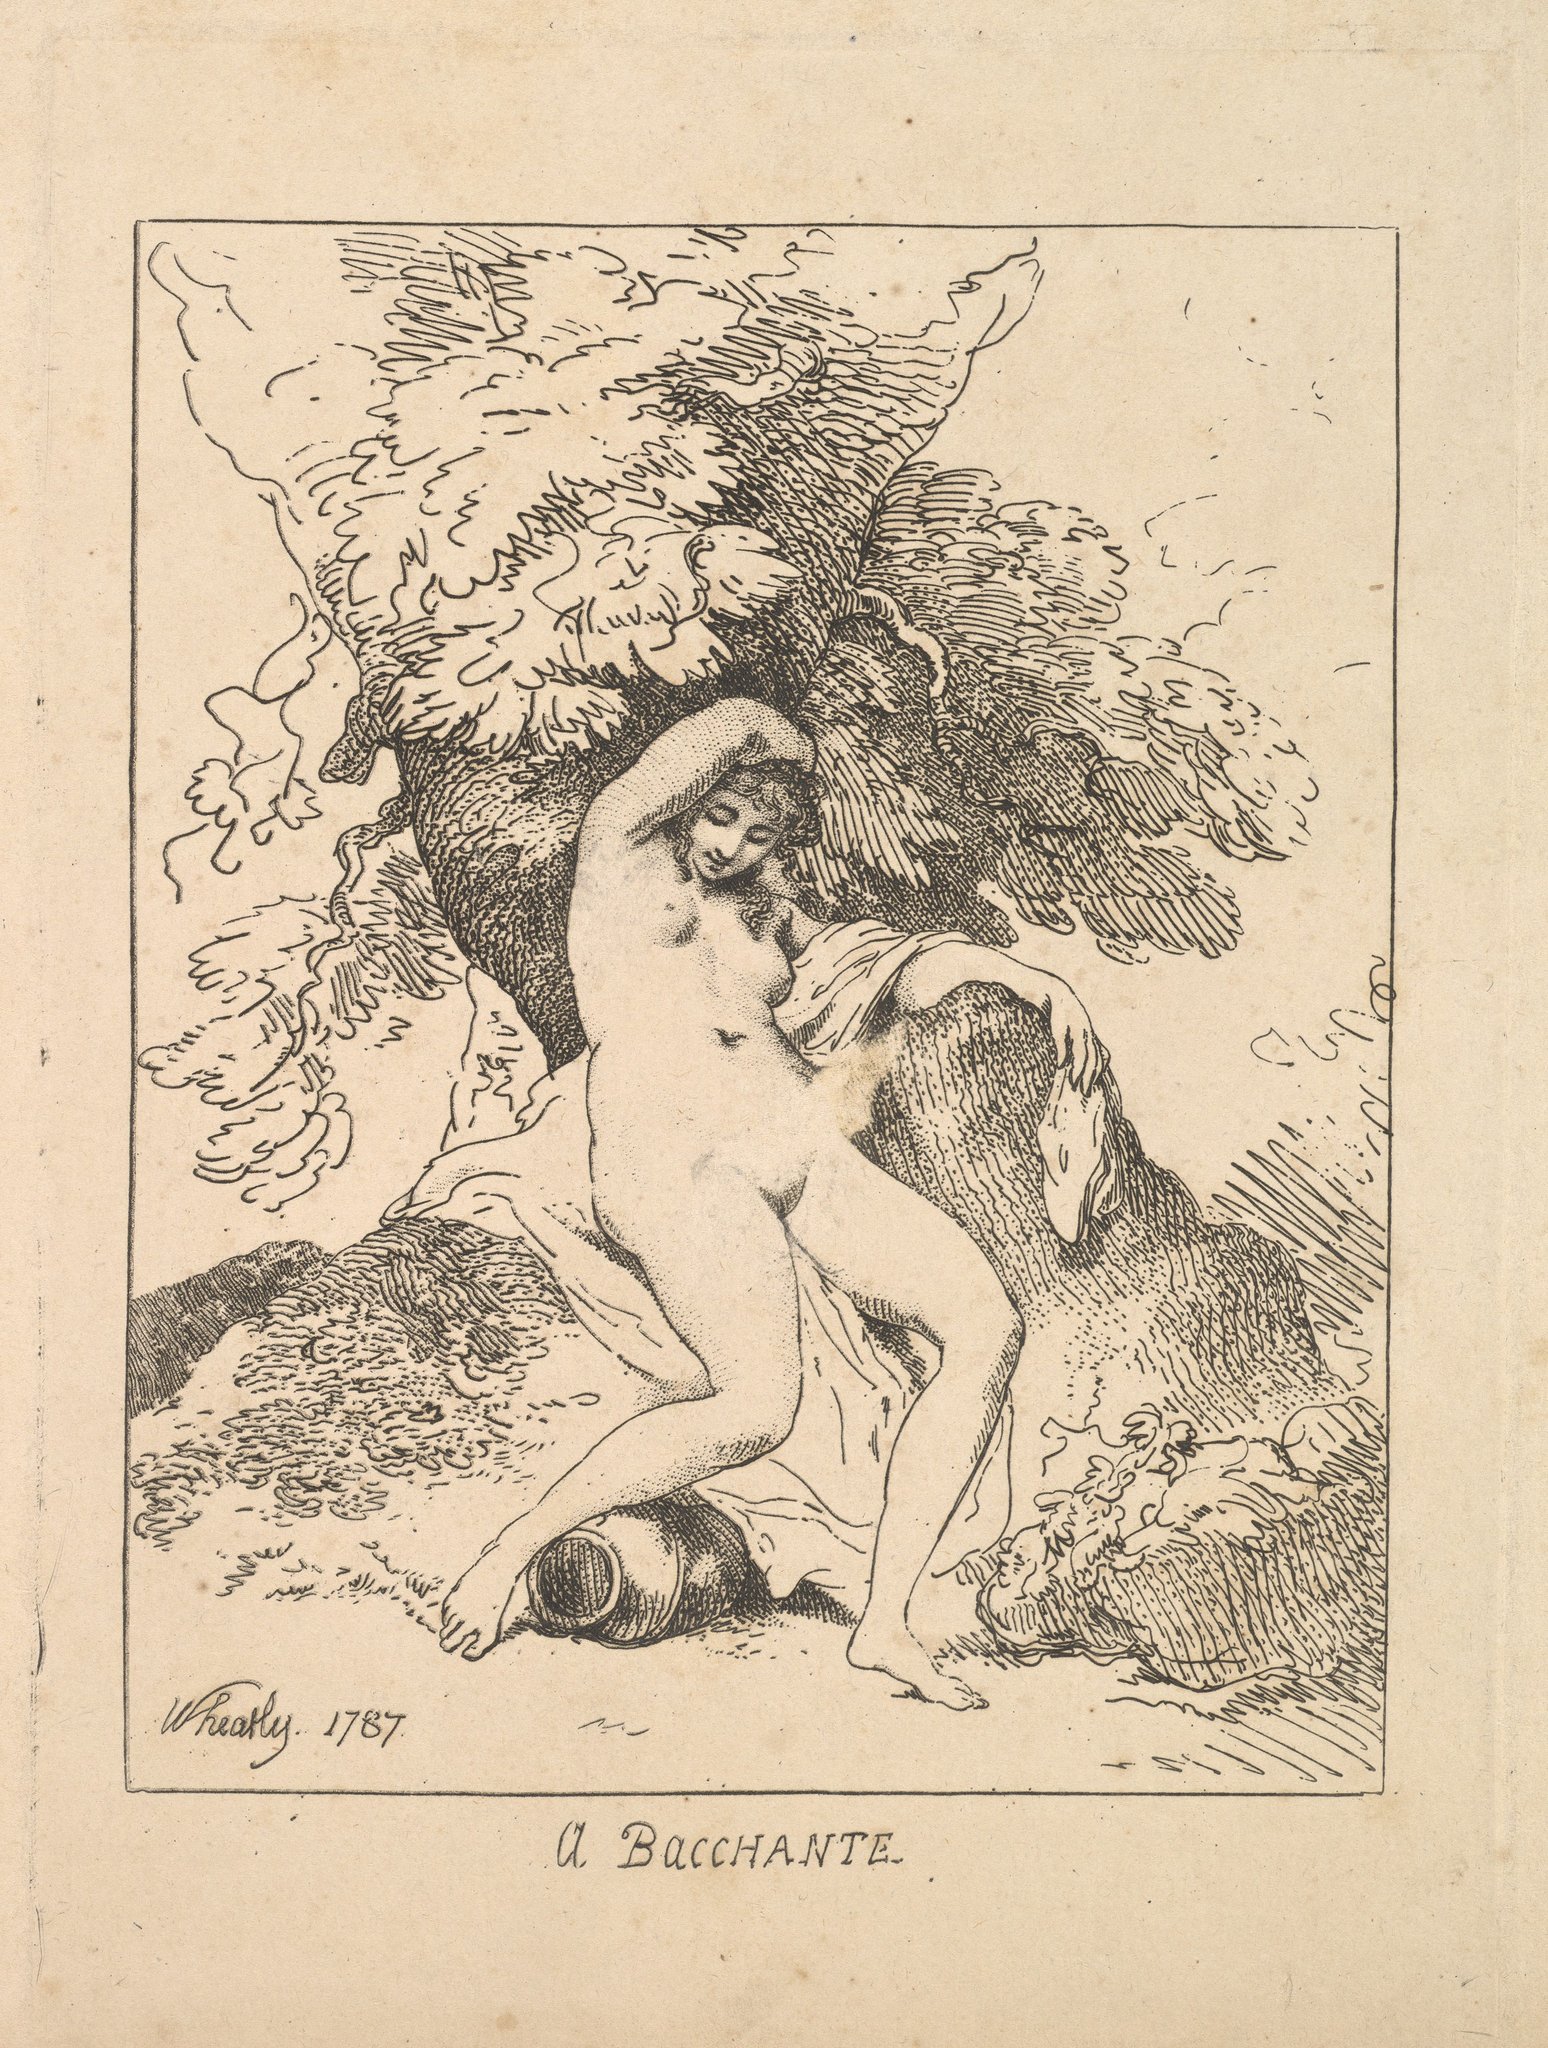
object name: print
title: A Bacchante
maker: thomas rowlandson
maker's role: artist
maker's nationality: british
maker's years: 1757-1827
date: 1787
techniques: etching, stippling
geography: england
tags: bacchantes